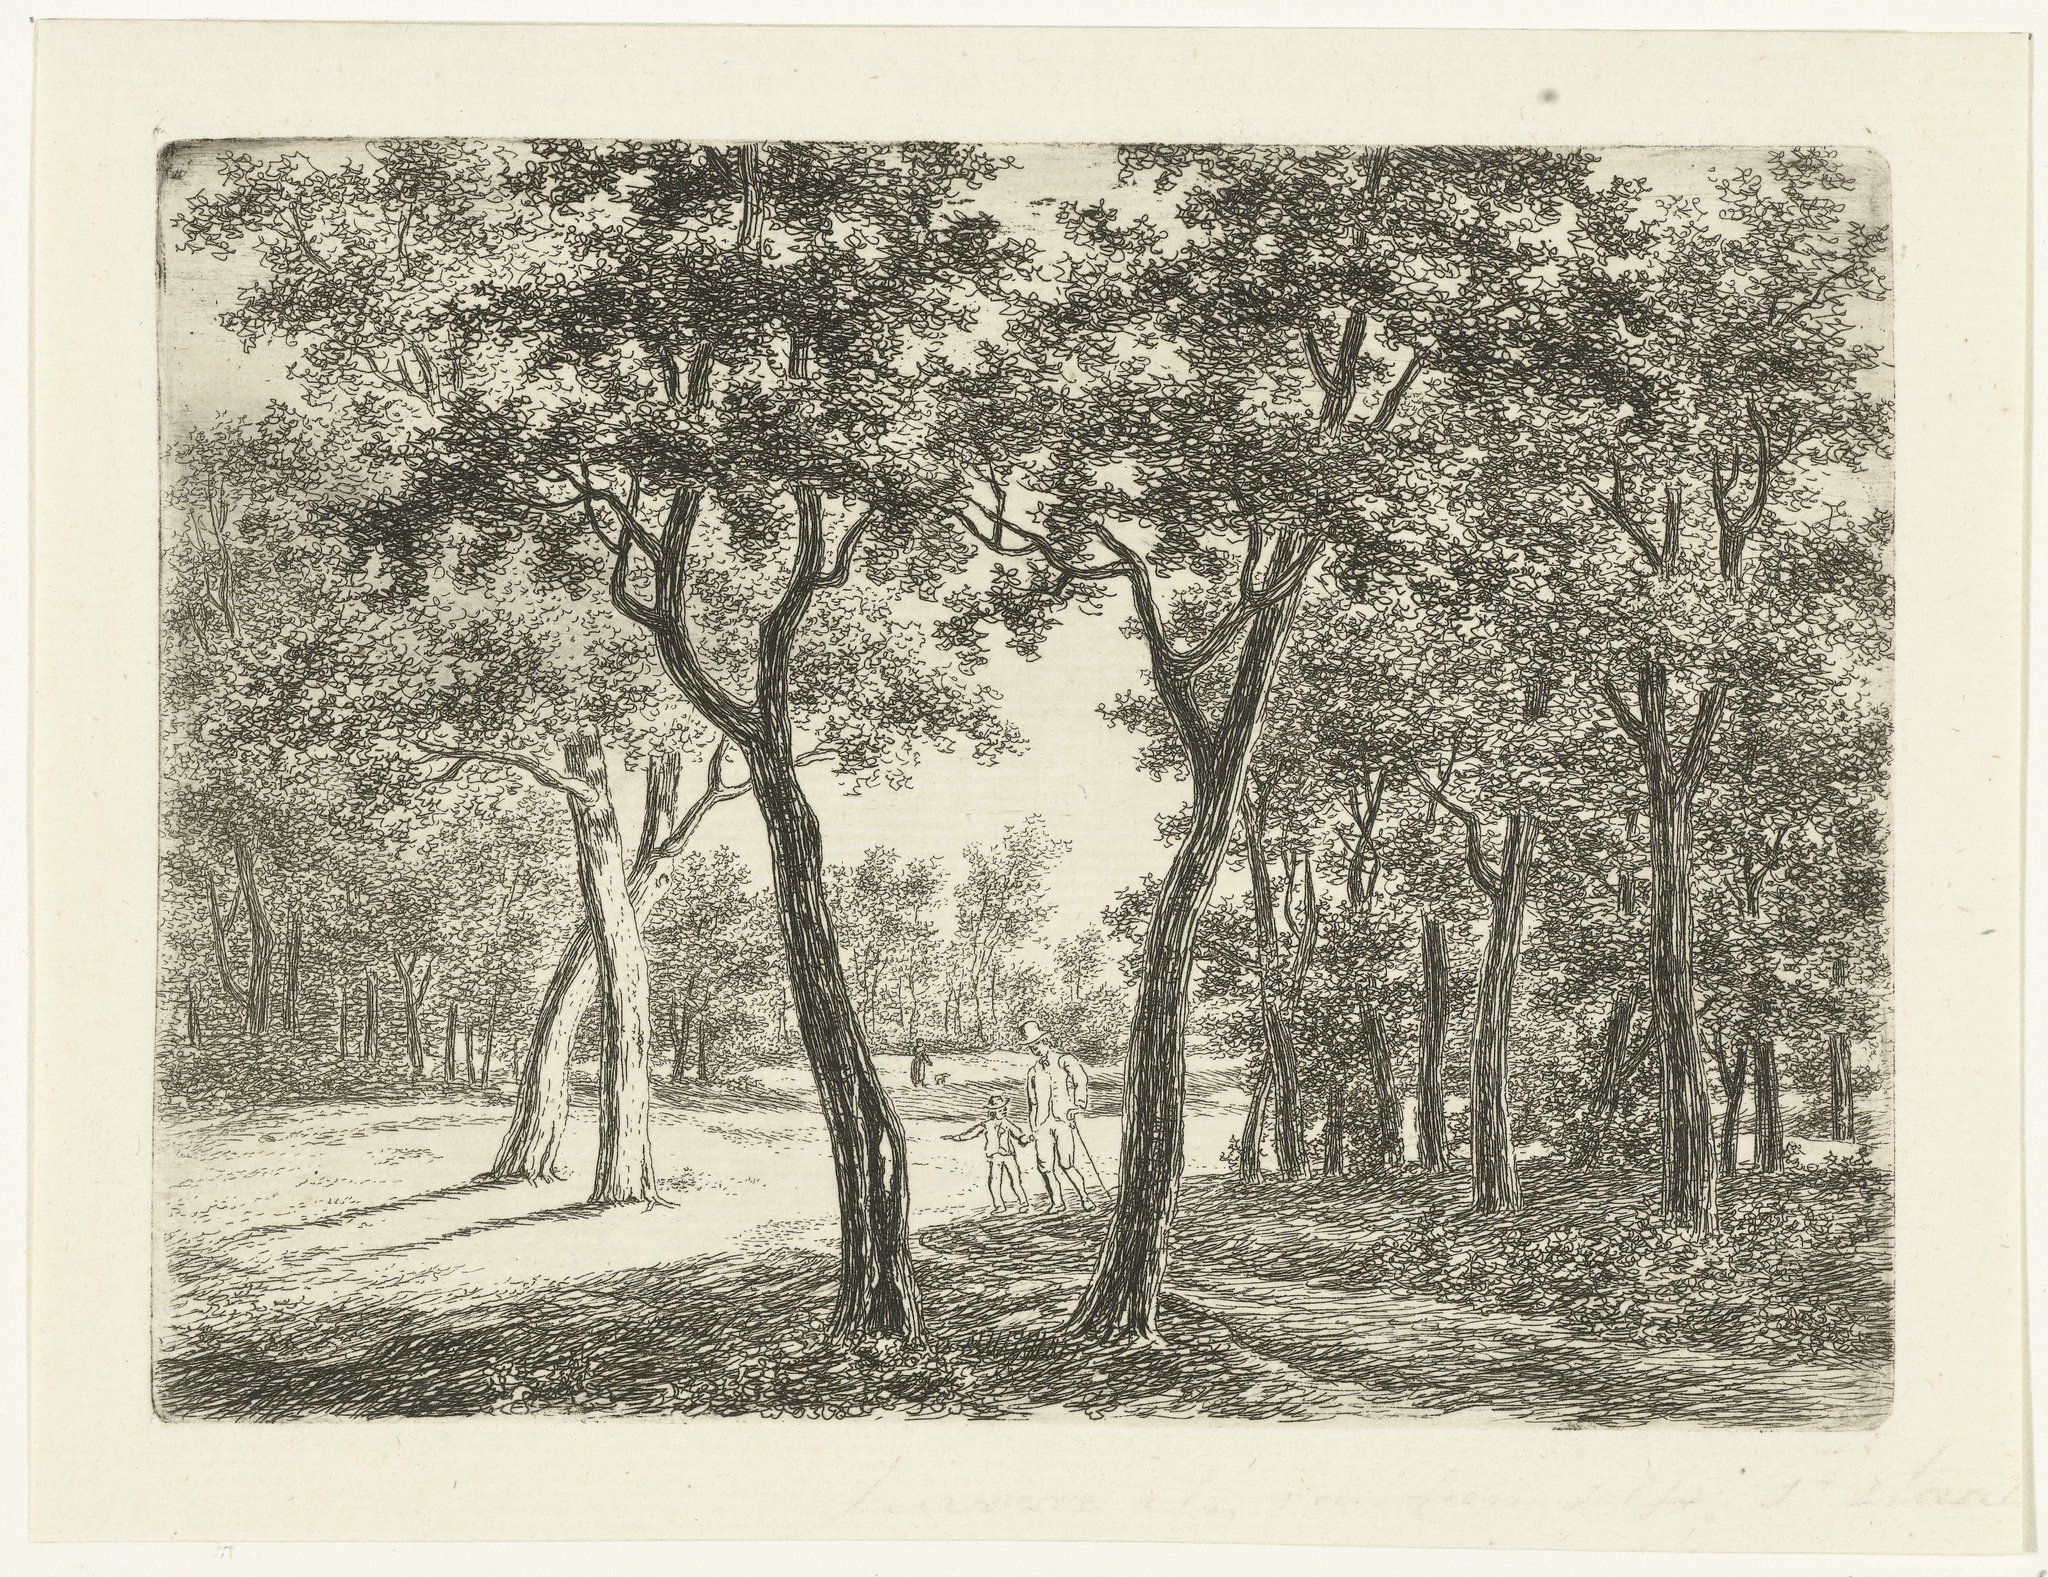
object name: print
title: Boslandschap met een man en een jongetje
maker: ernst willem jan bagelaar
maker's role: draughtsman, print maker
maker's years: 1775-1837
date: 1798-1837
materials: paper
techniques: etching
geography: netherlands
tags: forest, wood (+ landscape with figures, staffage)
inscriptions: collector's mark: Lugt 2228